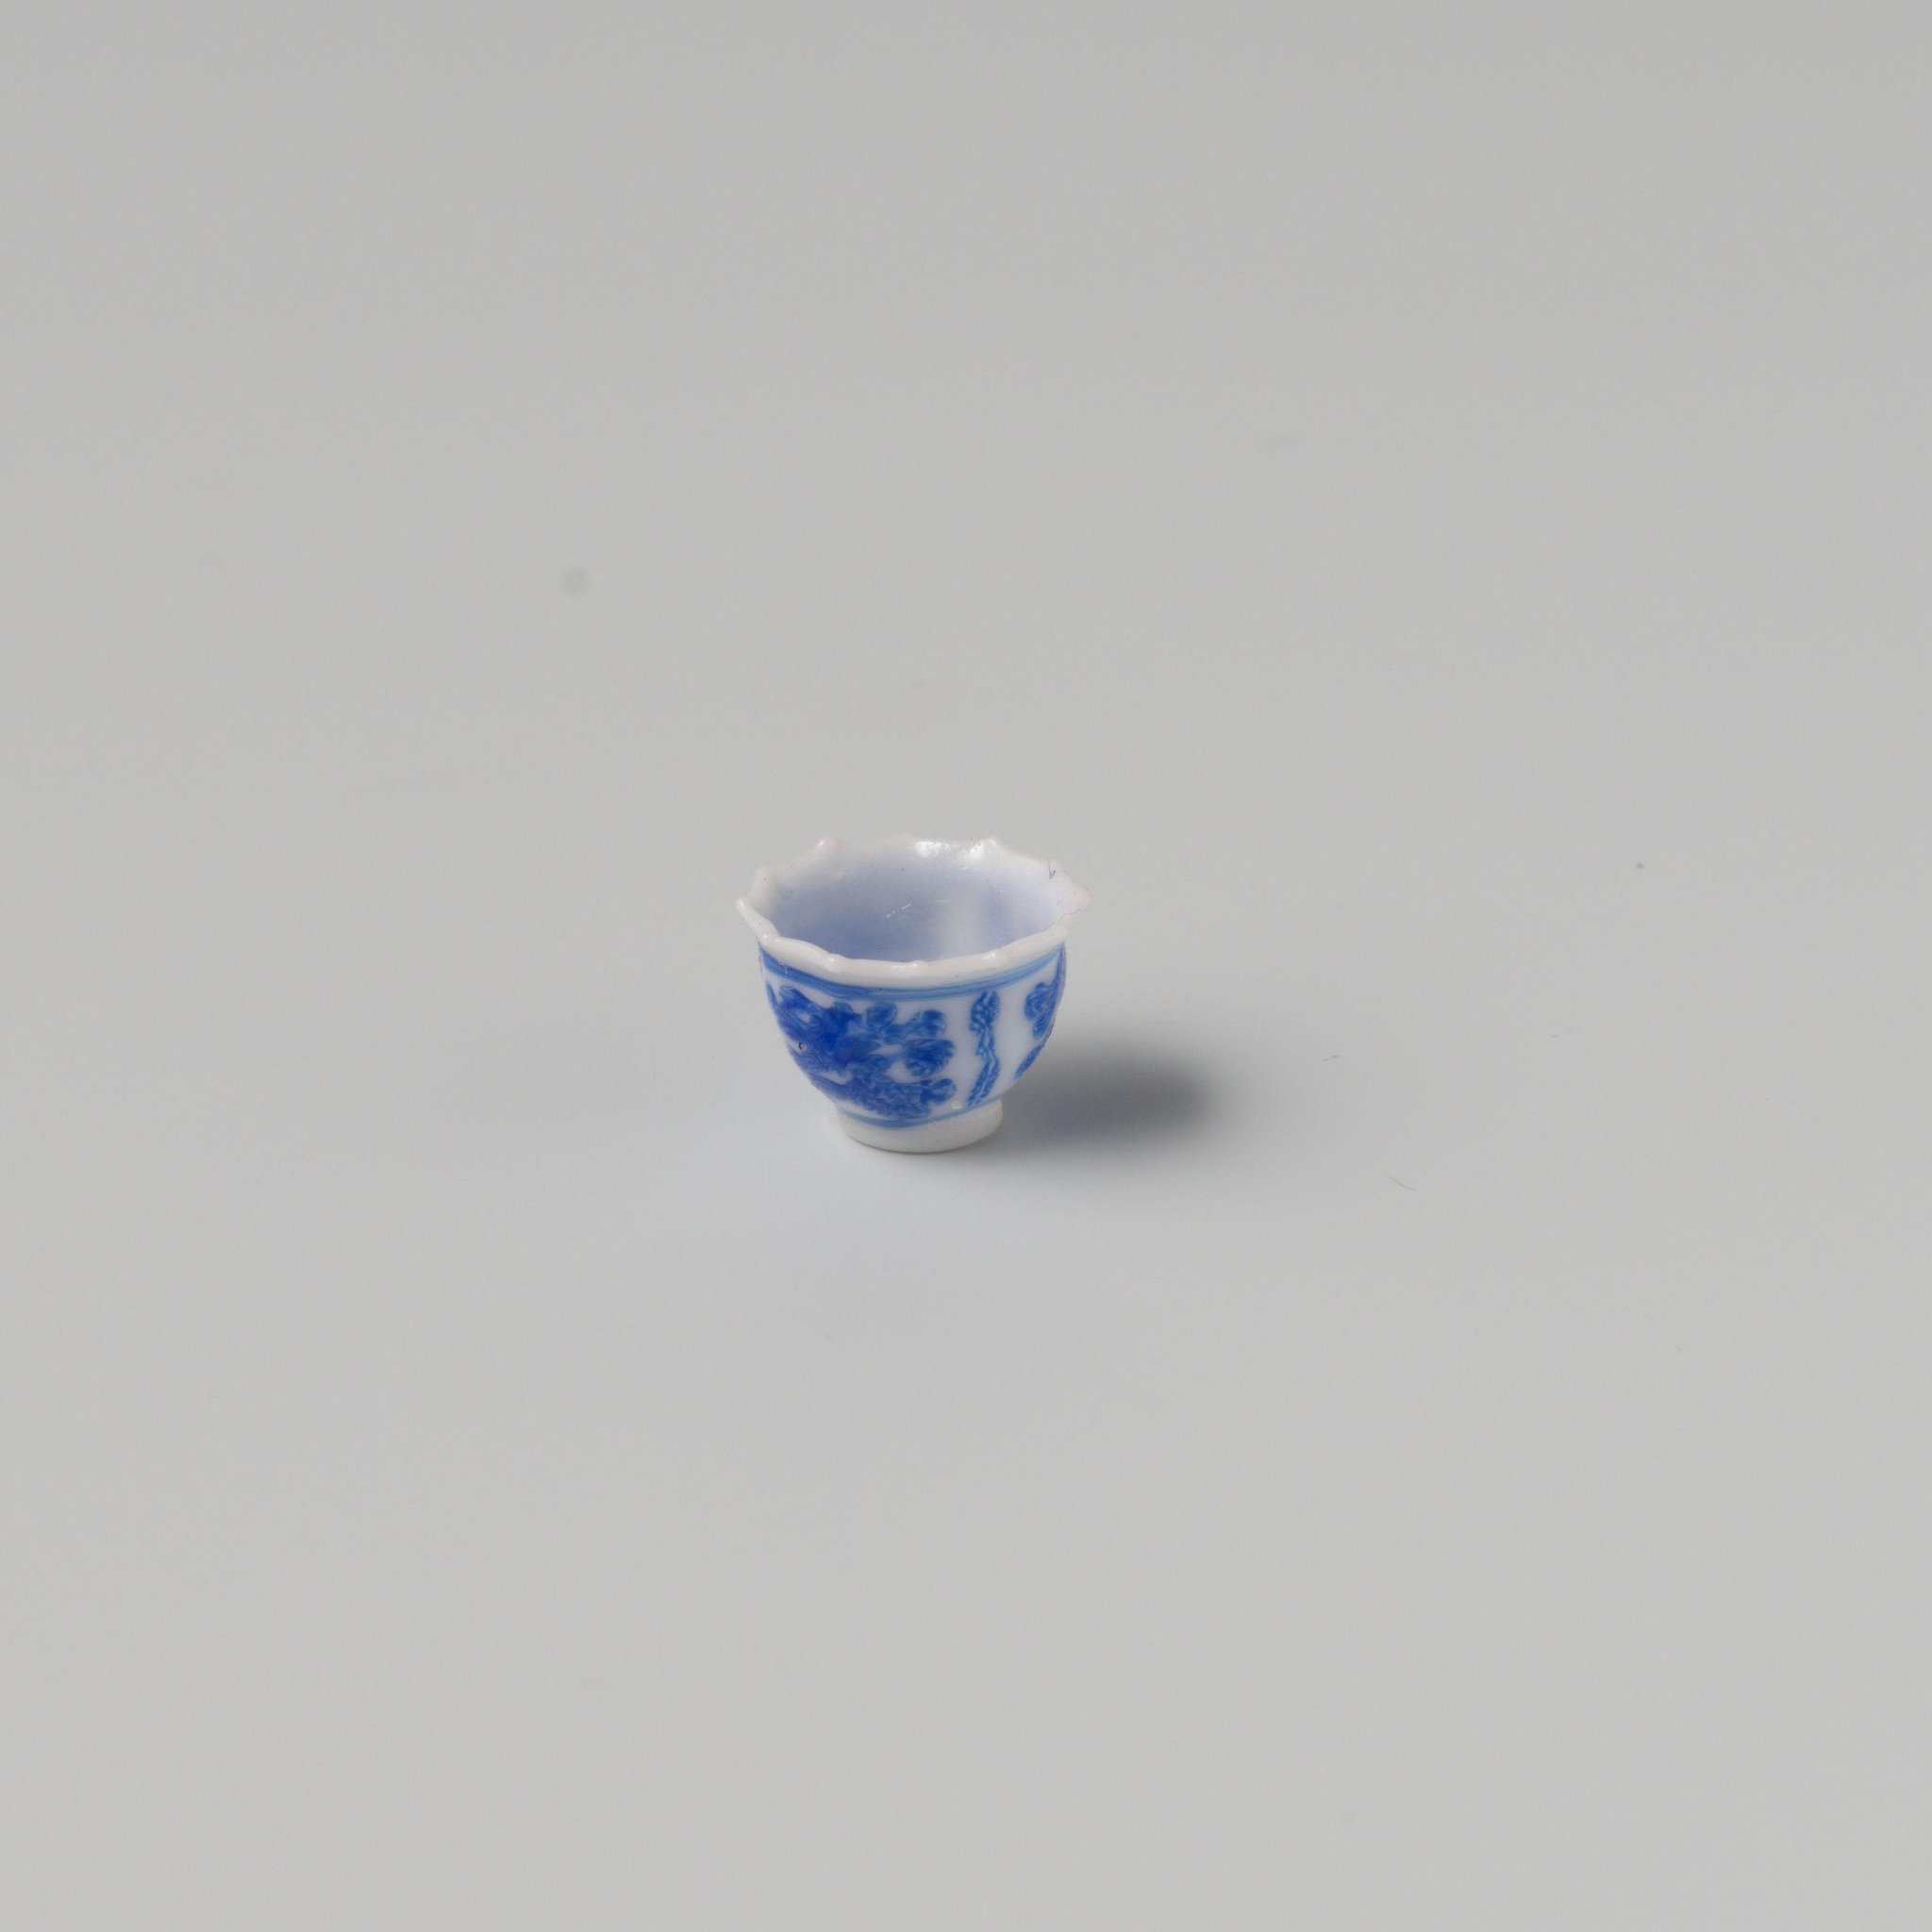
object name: miniature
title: Theekopje van melkglas met blauwe emailverf beschildering, imitatie Chinees porselein met 'bloem' decoratie in drie vakken; model met puntrand, nauwelijks een standring.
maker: Anonymous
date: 1675-1710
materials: glass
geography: amsterdam